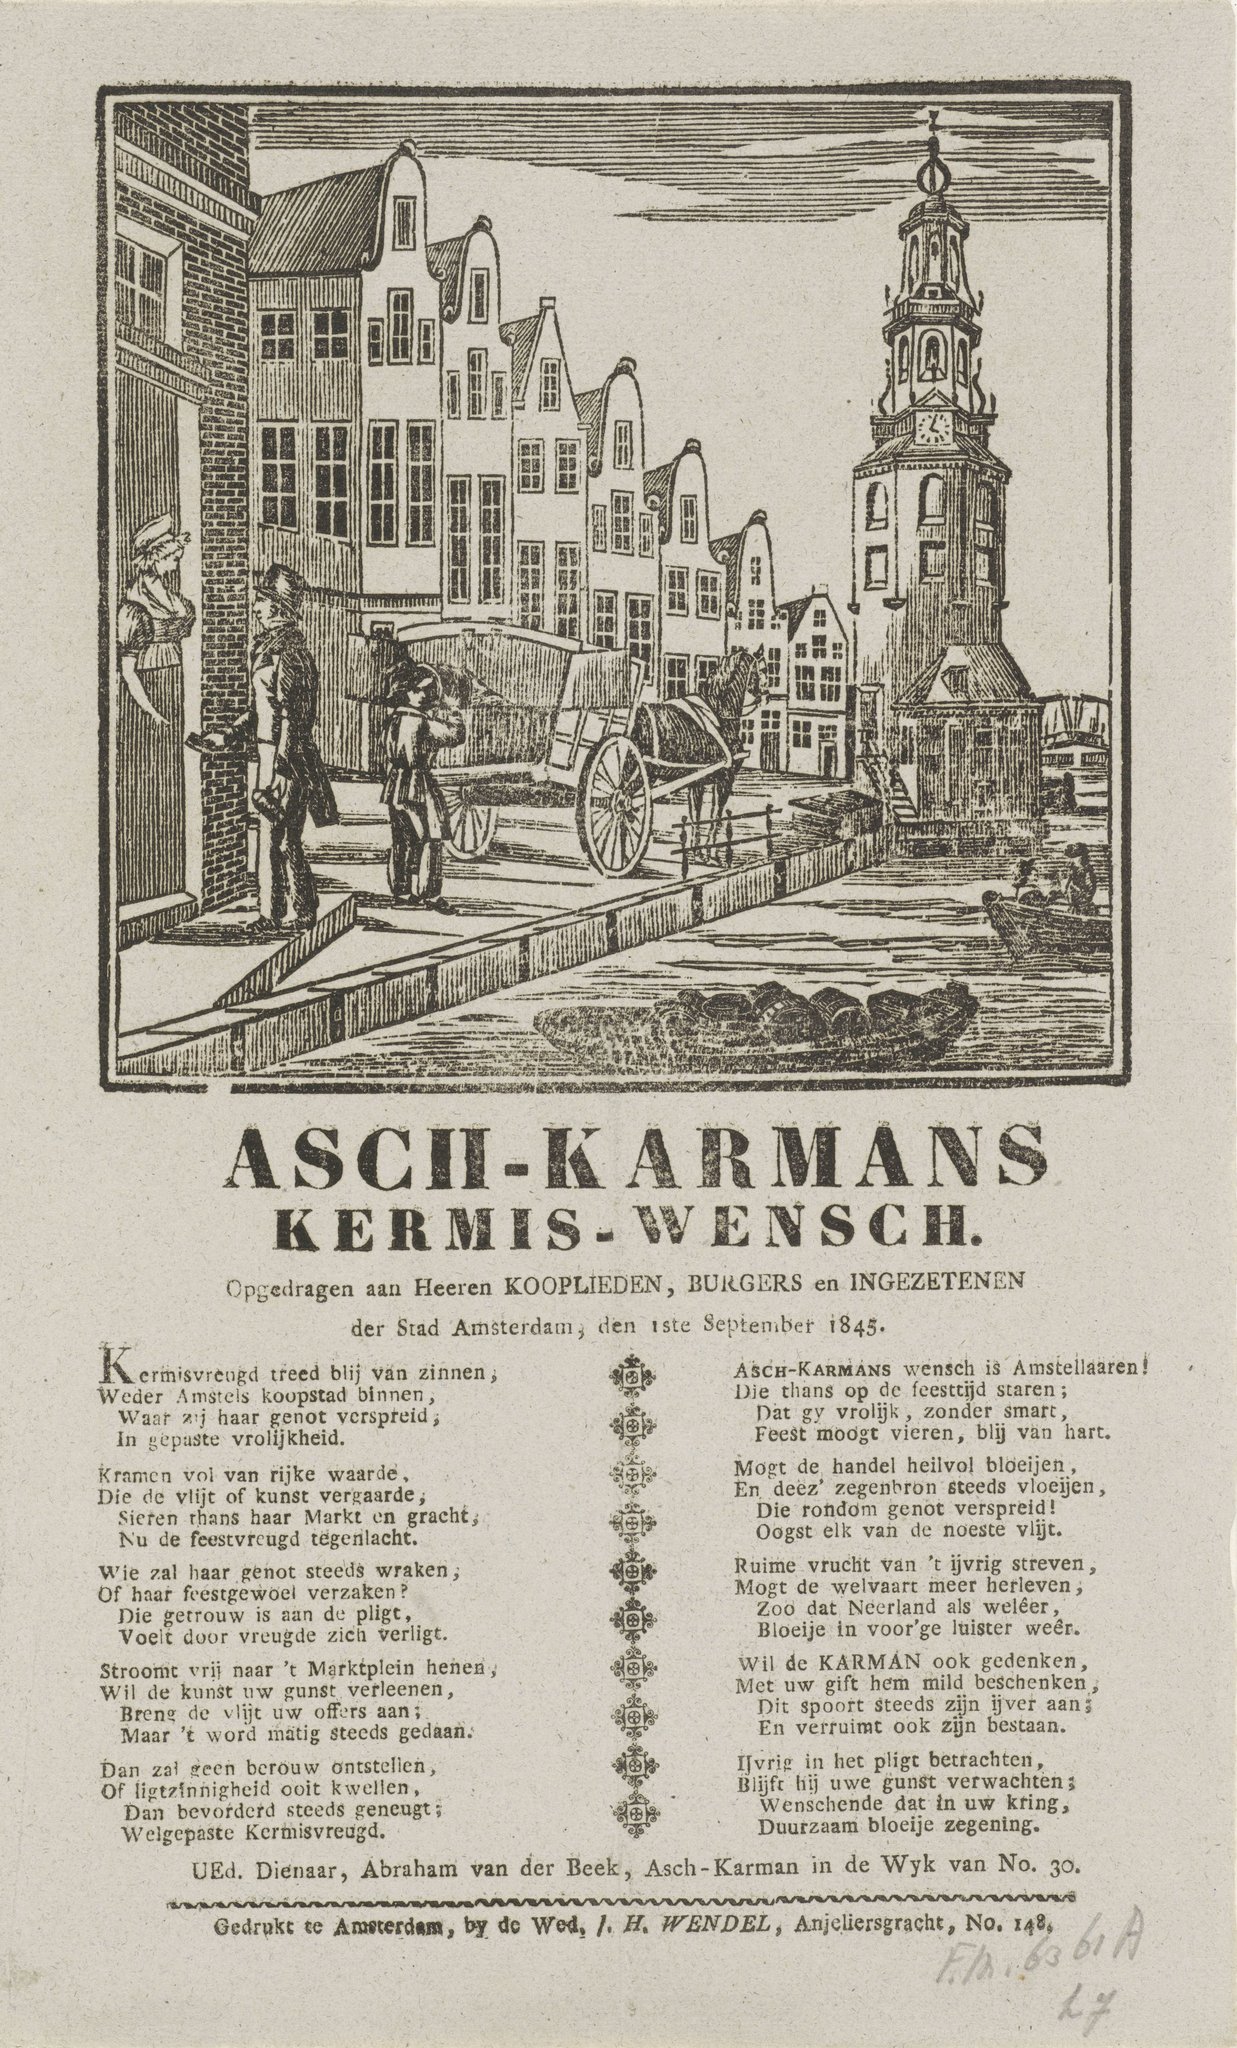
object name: fair print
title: Asch-Karmans Kermis-Wensch (...) 1845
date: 1845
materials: paper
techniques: letterpress printing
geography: amsterdam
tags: public road - ii - ideal city, garbage collection, amsterdam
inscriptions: collector's mark: Lugt 2228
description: Kermisprent namens de askarrenmannen (karrenman of vuilnisman) te Amsterdam, 1 september 1845. Gezicht op de Oude Schans met de Montelbaanstoren te Amsterdam met een man die een asemmer in de kar leegkiepert terwijl een andere man aan huis geld ophaalt. Onderaan een gedicht in twee kolommen. Namens Abraham van der Beek, de askarreman van wijk no. 30.